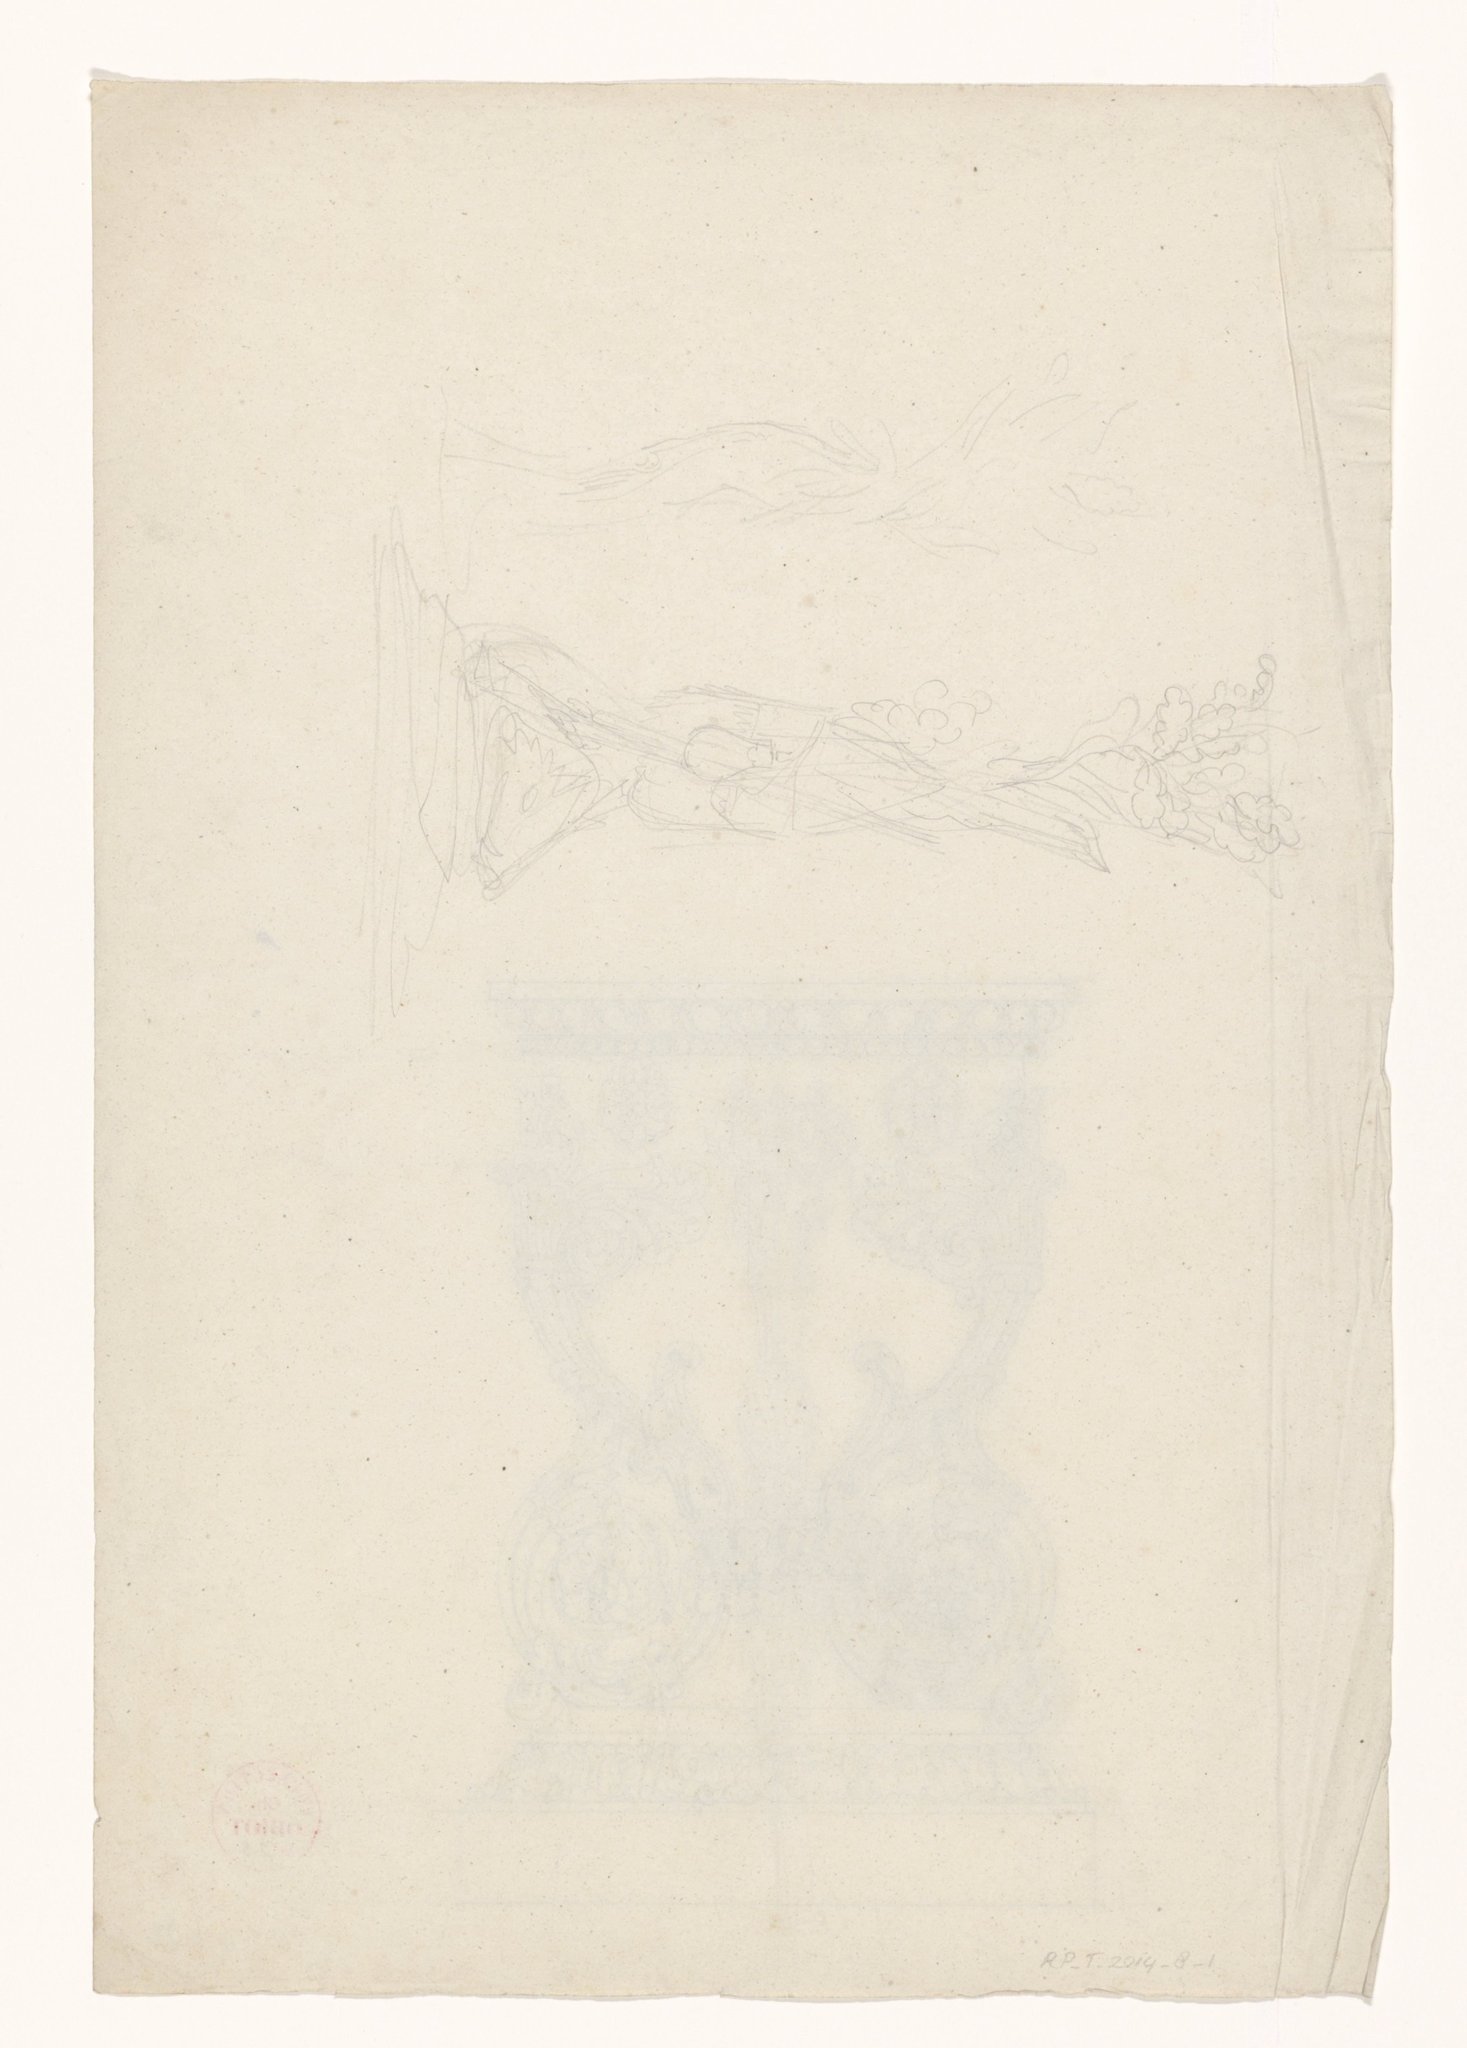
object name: design drawing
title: Schetsen voor jachttrofee (voet kandelaar?)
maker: charles nicolas odiot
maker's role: jeweler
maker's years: 1789-1869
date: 1825-1830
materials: paper, pencil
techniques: drawing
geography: paris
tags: chandelier, candelabrum, ornament ~ candelabrum, hunting trophies